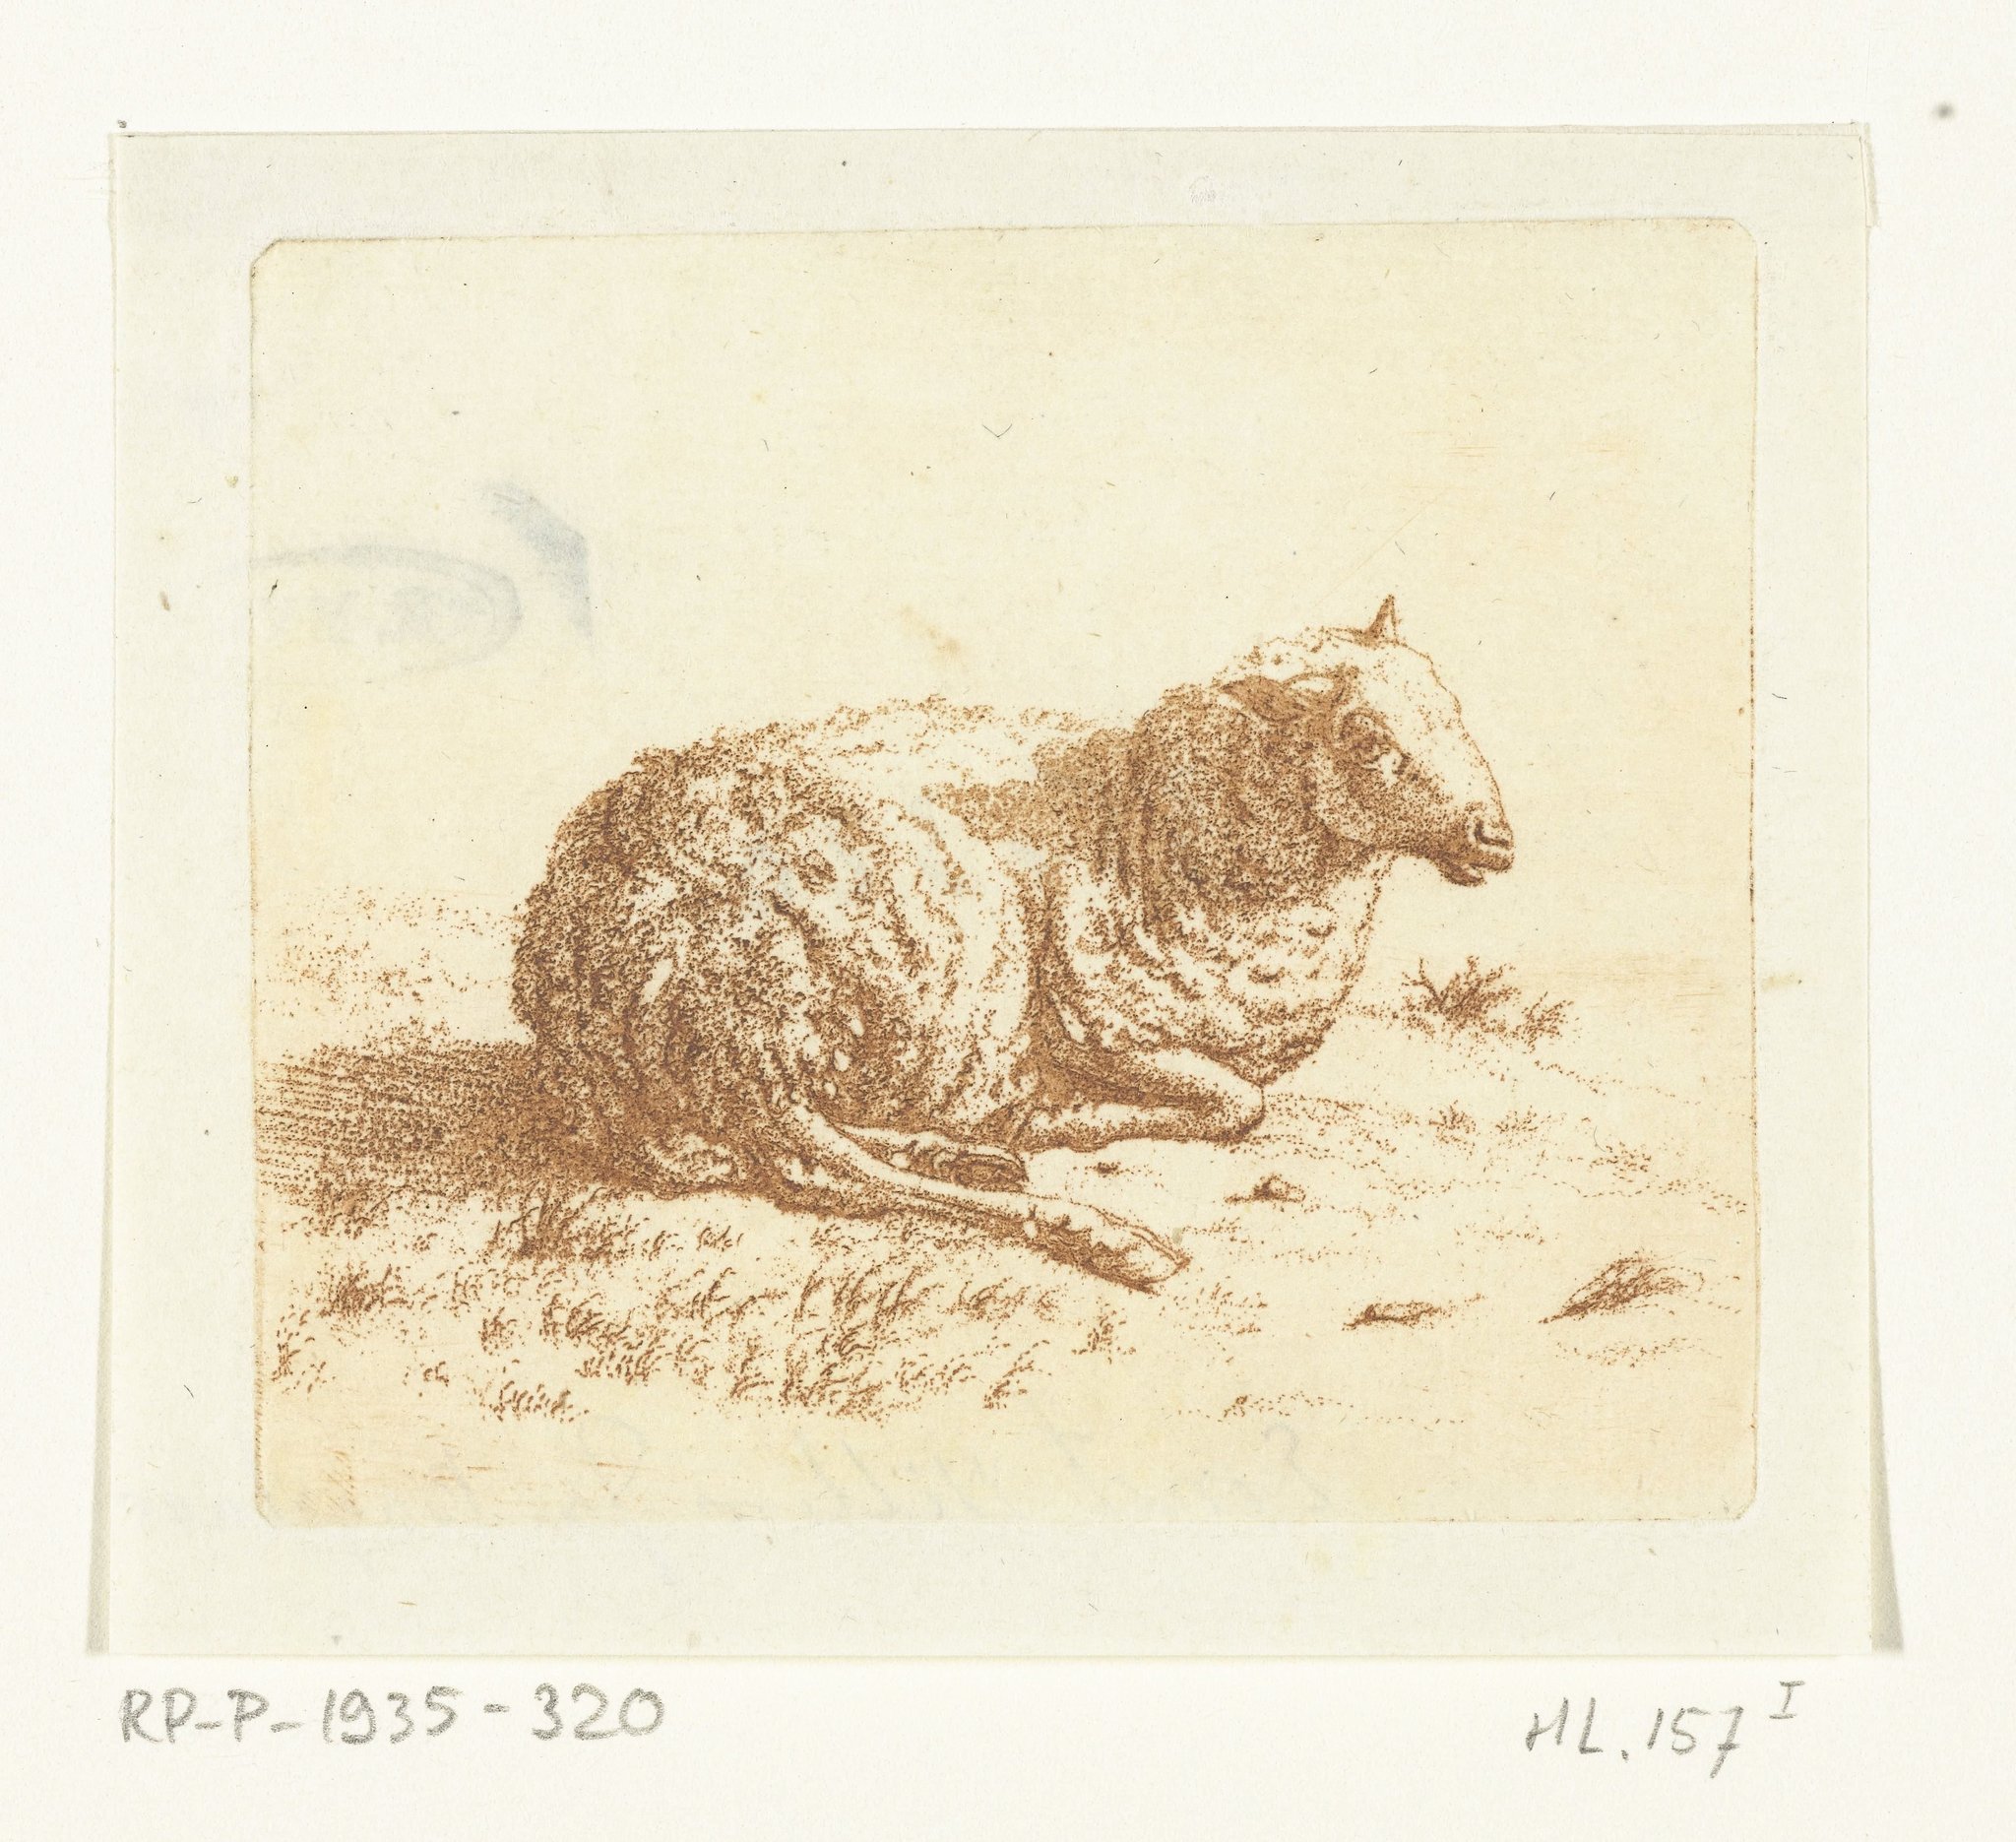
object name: print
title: Liggend schaap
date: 1798-1837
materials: paper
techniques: printmaking, etching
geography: netherlands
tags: sheep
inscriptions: collector's mark: Lugt 2228, collector's mark: Lugt 2760